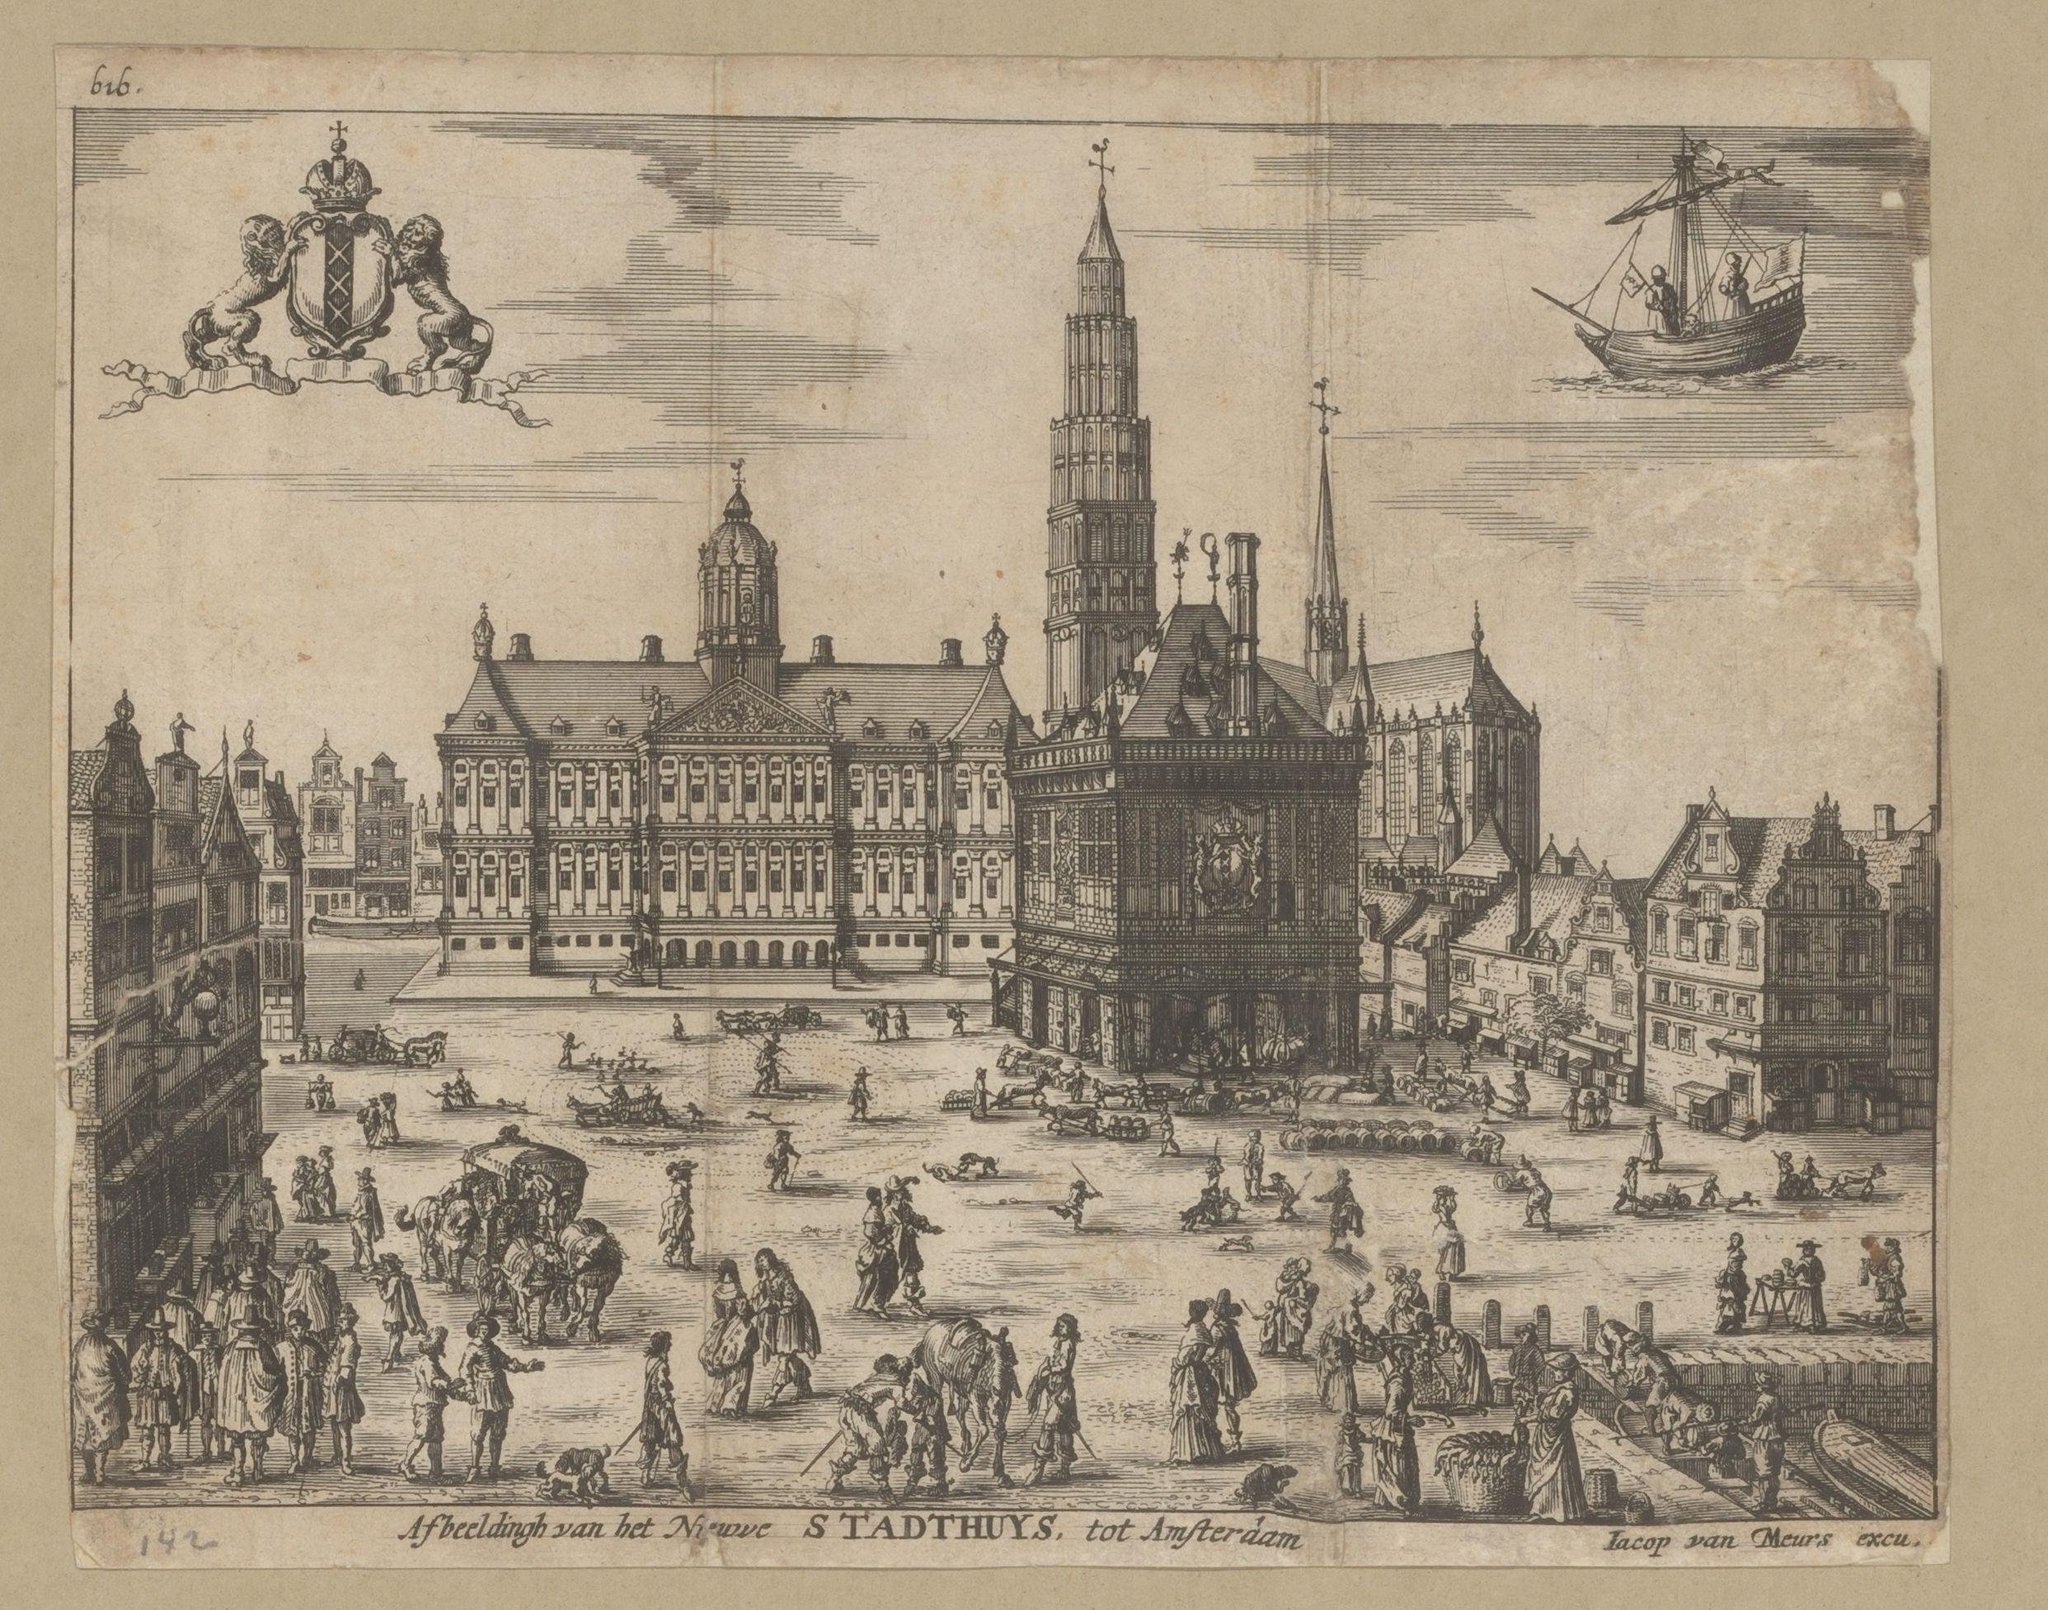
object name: print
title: Gezicht op het Stadhuis, de Nieuwe Kerk en de Waag op de Dam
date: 1629-1680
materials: paper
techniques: engraving, etching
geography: amsterdam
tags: square, place, circus, etc., city-view in general; 'veduta', church (exterior), townhall, weigh-house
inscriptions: collector's mark: ‘7’ Lugt 1641b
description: Onderwerpsrubriek binnen de Atlas Amsterdam: Dam (voor 1835).